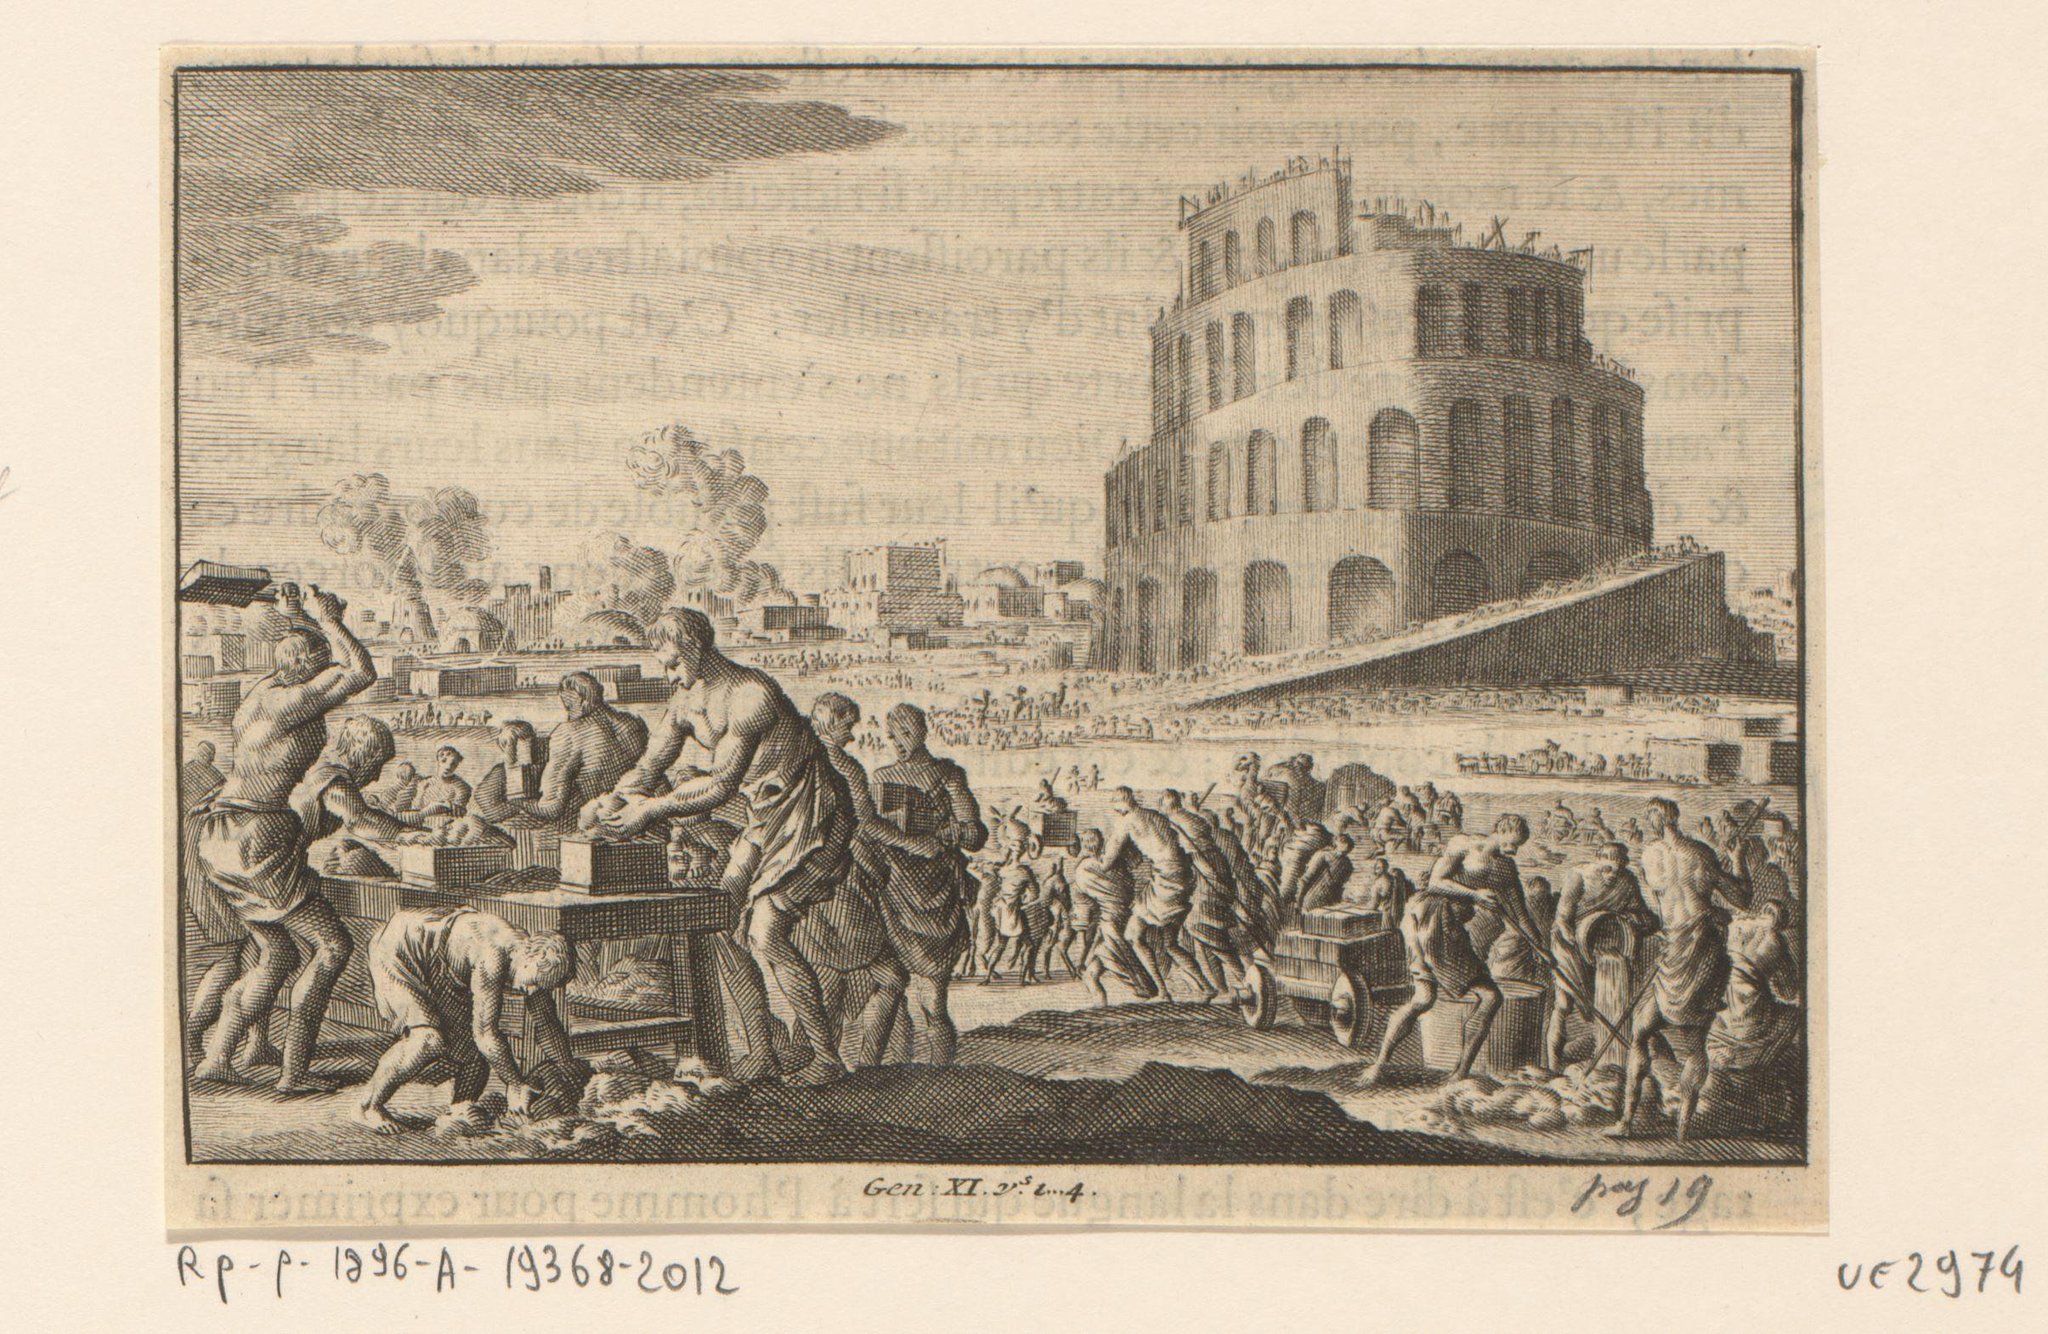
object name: print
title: Bouw van de toren van Babel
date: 1703-1762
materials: paper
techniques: etching, letterpress printing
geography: amsterdam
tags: the building of the tower of babel; nimrod may be present, supervising or assisting the construction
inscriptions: collector's mark: Lugt 2228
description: De prent komt een eerste keer voor als boekillustratie voor David Martin. Historie des Ouden en Nieuwen Testaments. Amsterdam, Pieter Mortier, 1703. Deel I. De boekillustraties voor de Mortierbijbel hebben verschillende staten en kopieën, waarbij de chronologische volgorde moeilijk te achterhalen valt. Als boekillustraties werden ze bovendien herhaaldelijk opnieuw gebruikt voor andere boekwerken.